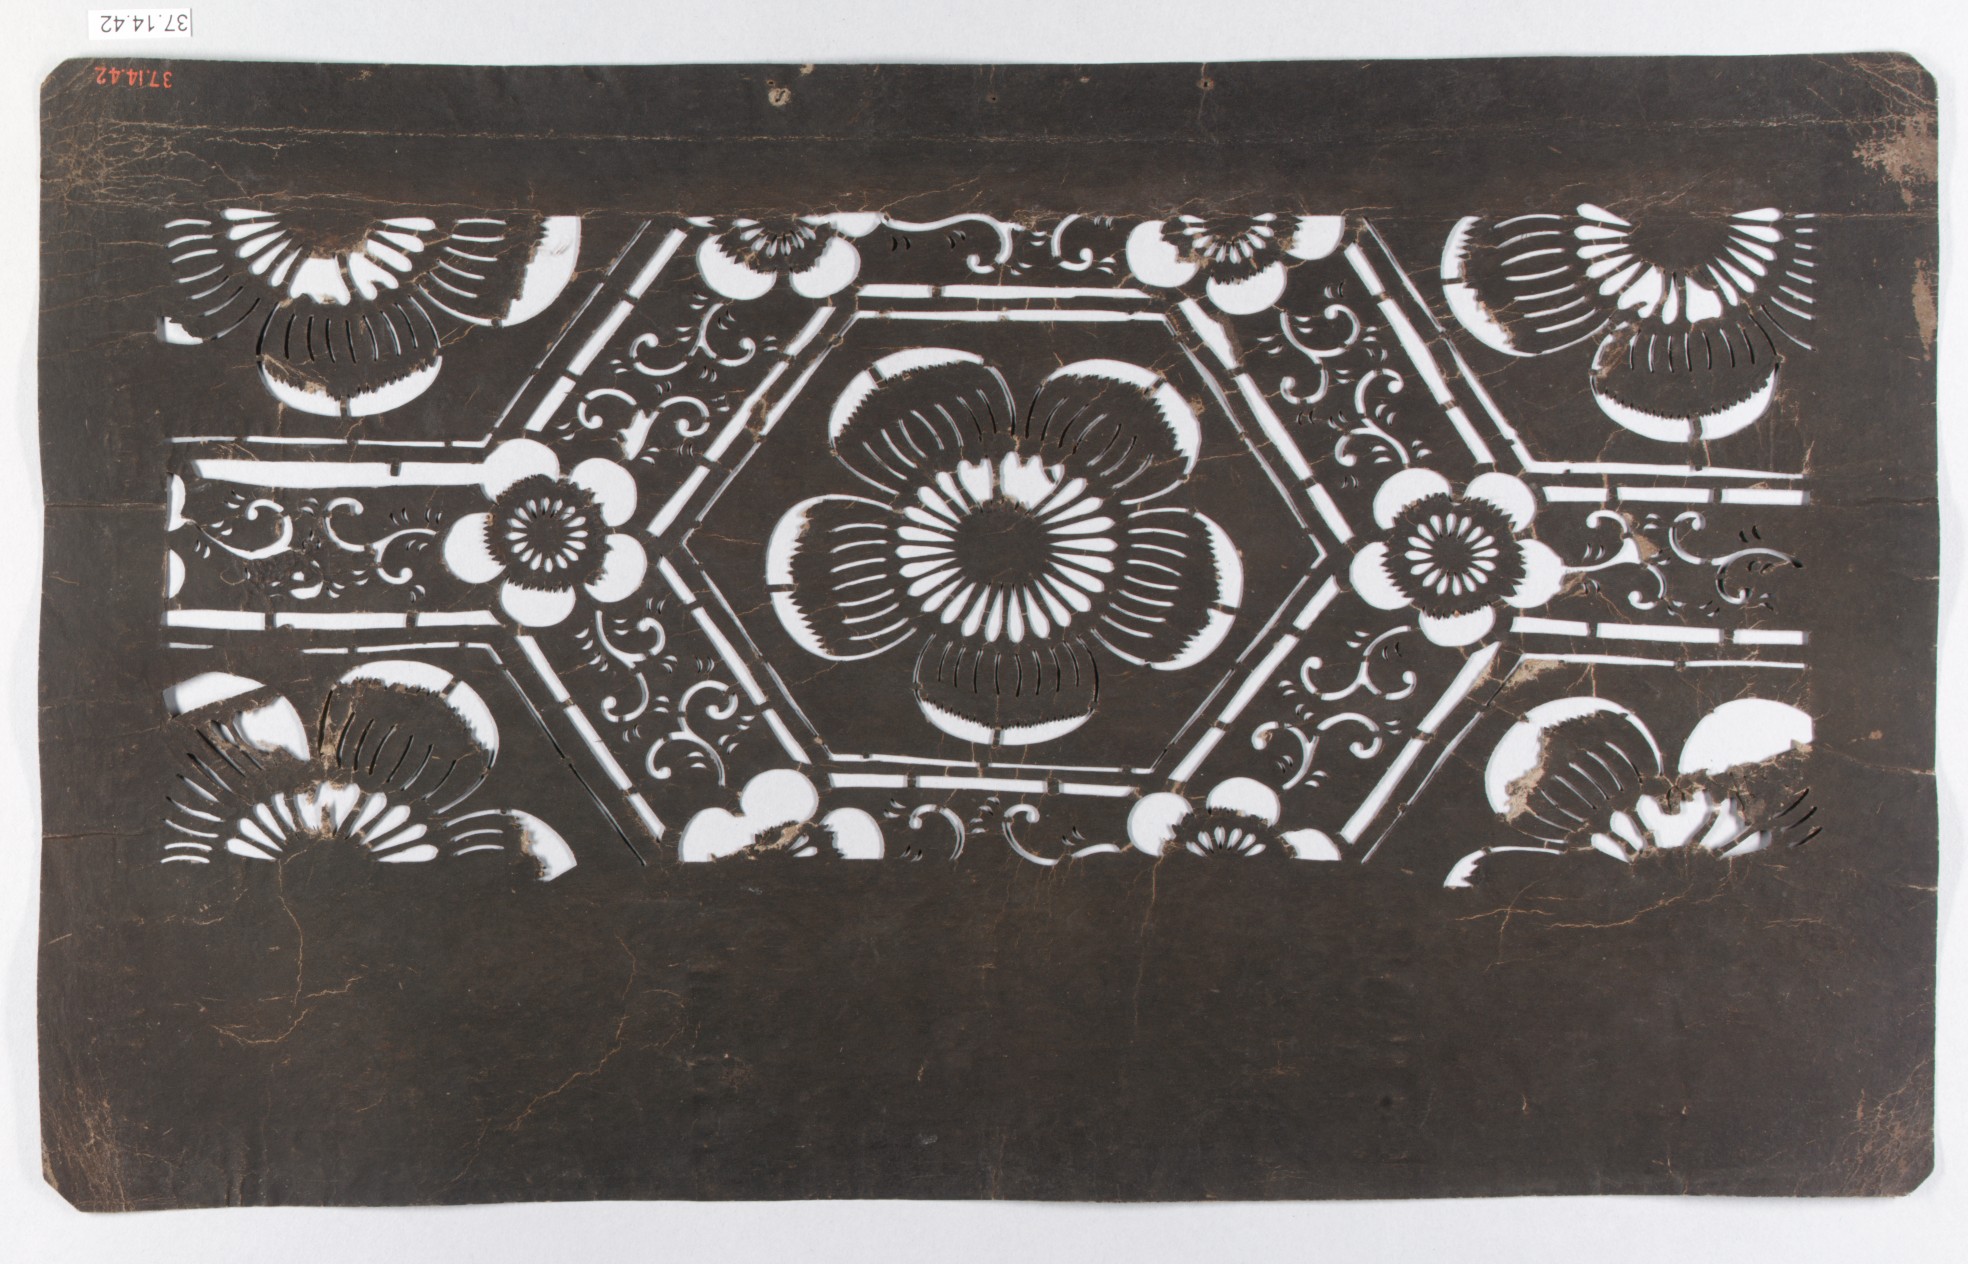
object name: stencil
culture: japanese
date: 1801-1833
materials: paper